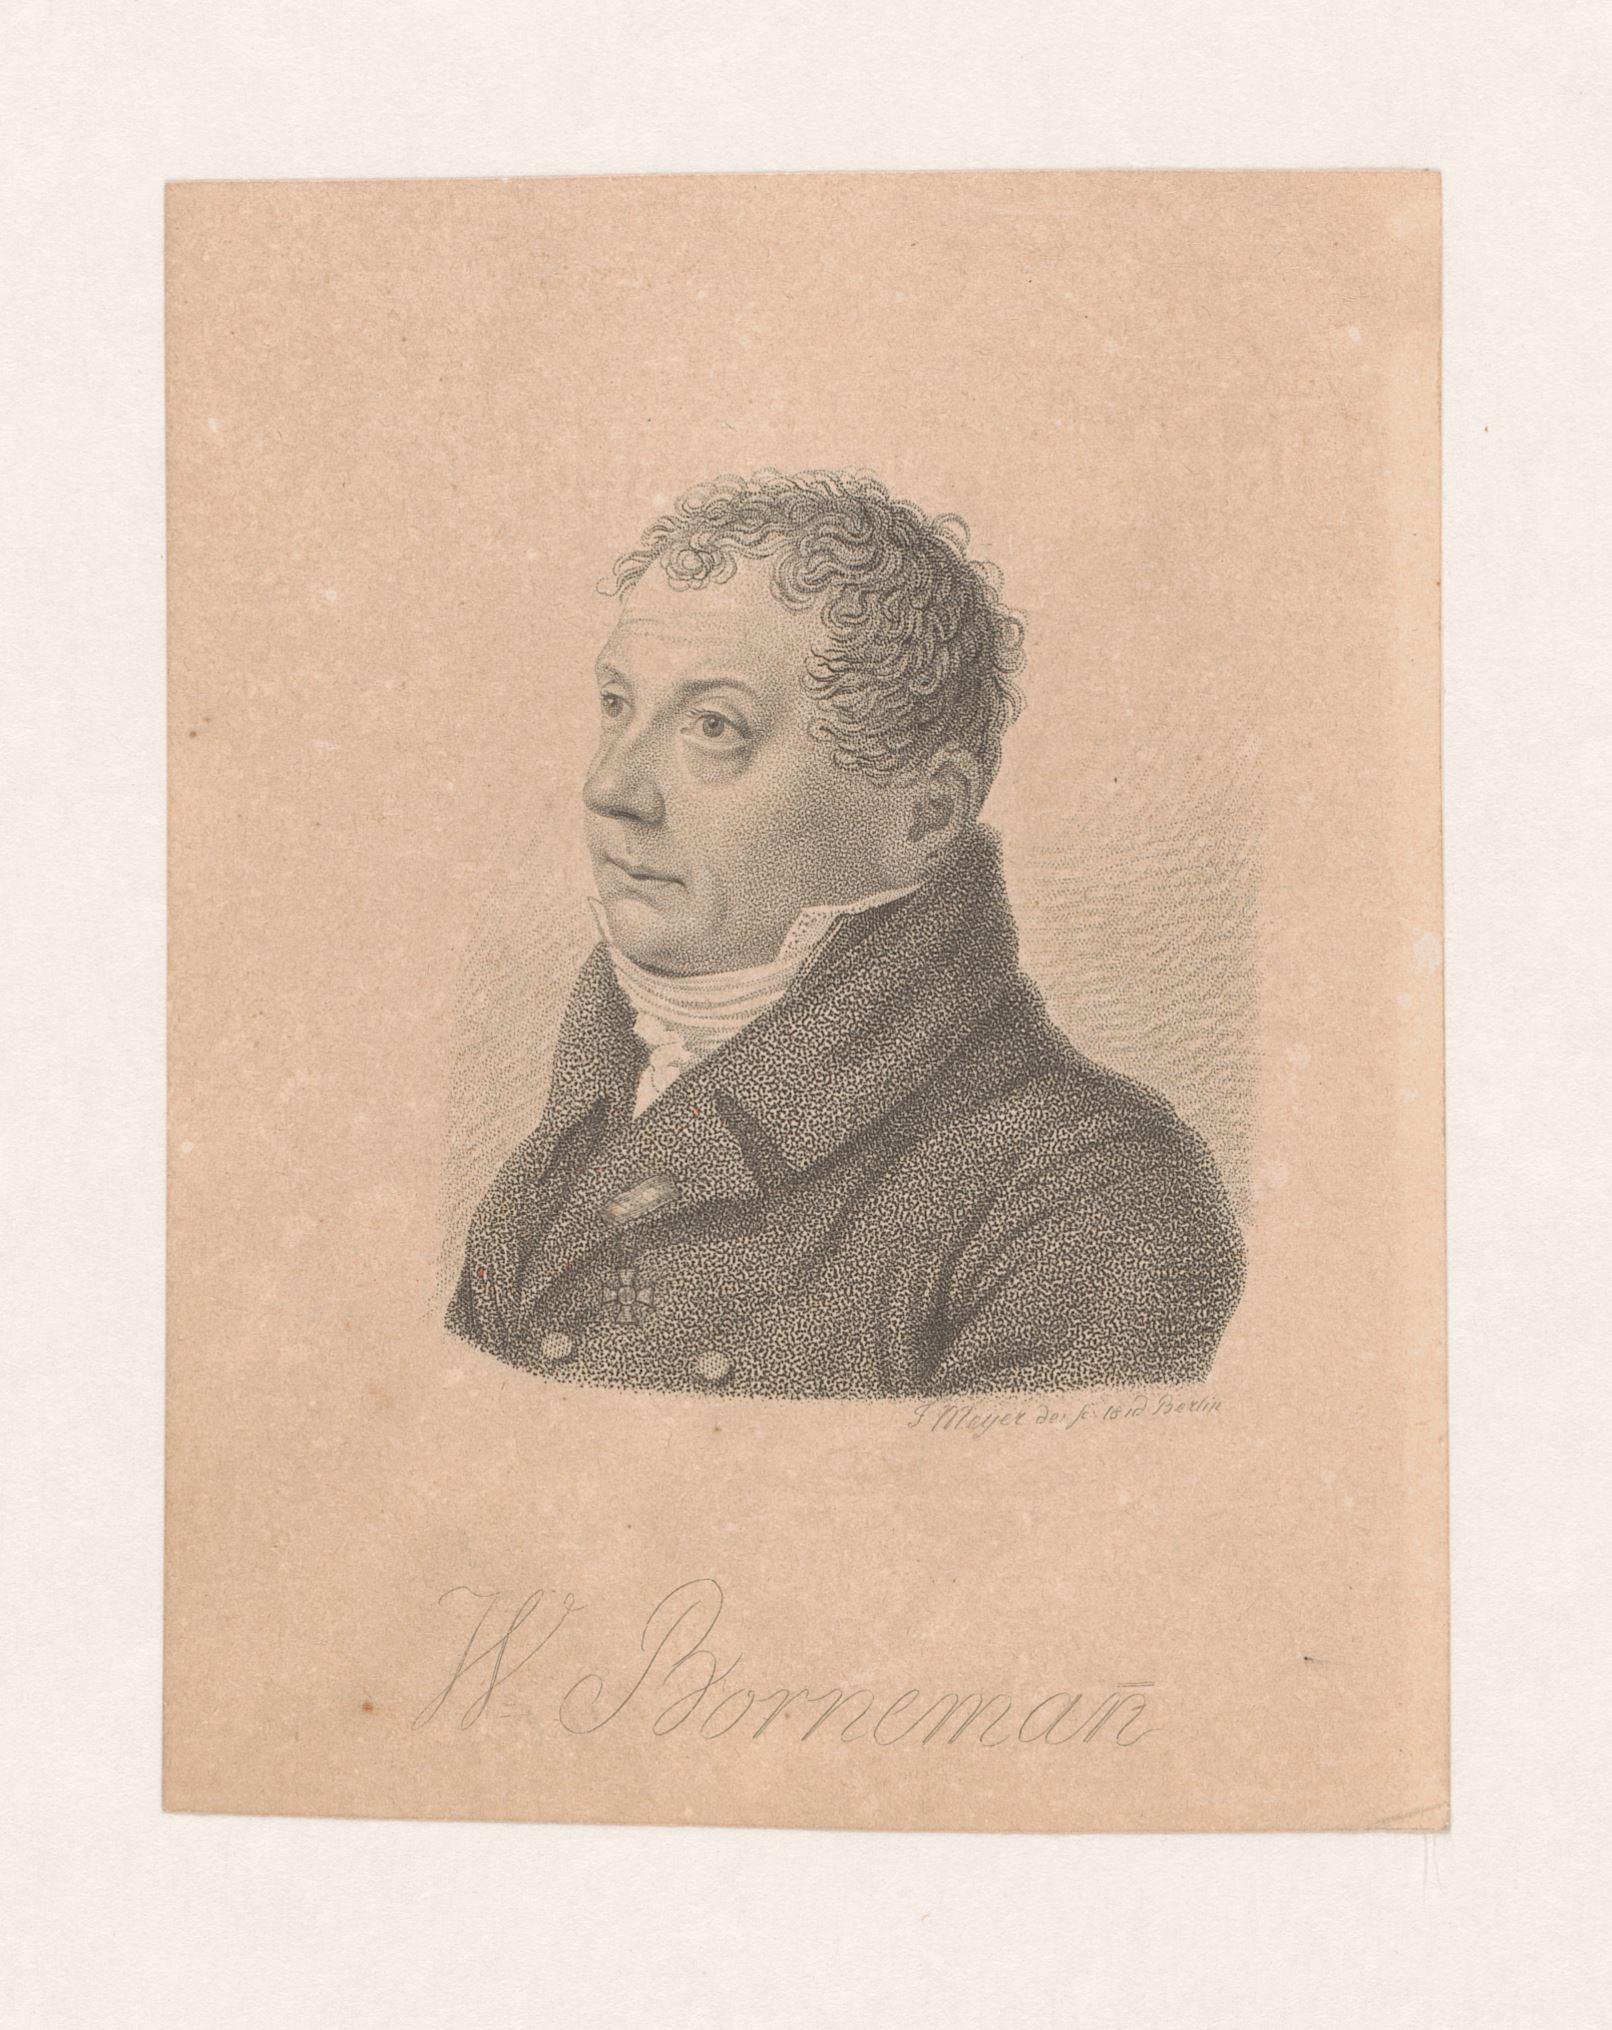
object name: print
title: Portret van W. Borneman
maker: j. meyer (graveur)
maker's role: print maker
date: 1816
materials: paper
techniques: engraving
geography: berlin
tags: historical persons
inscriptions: collector's mark: Lugt 2228